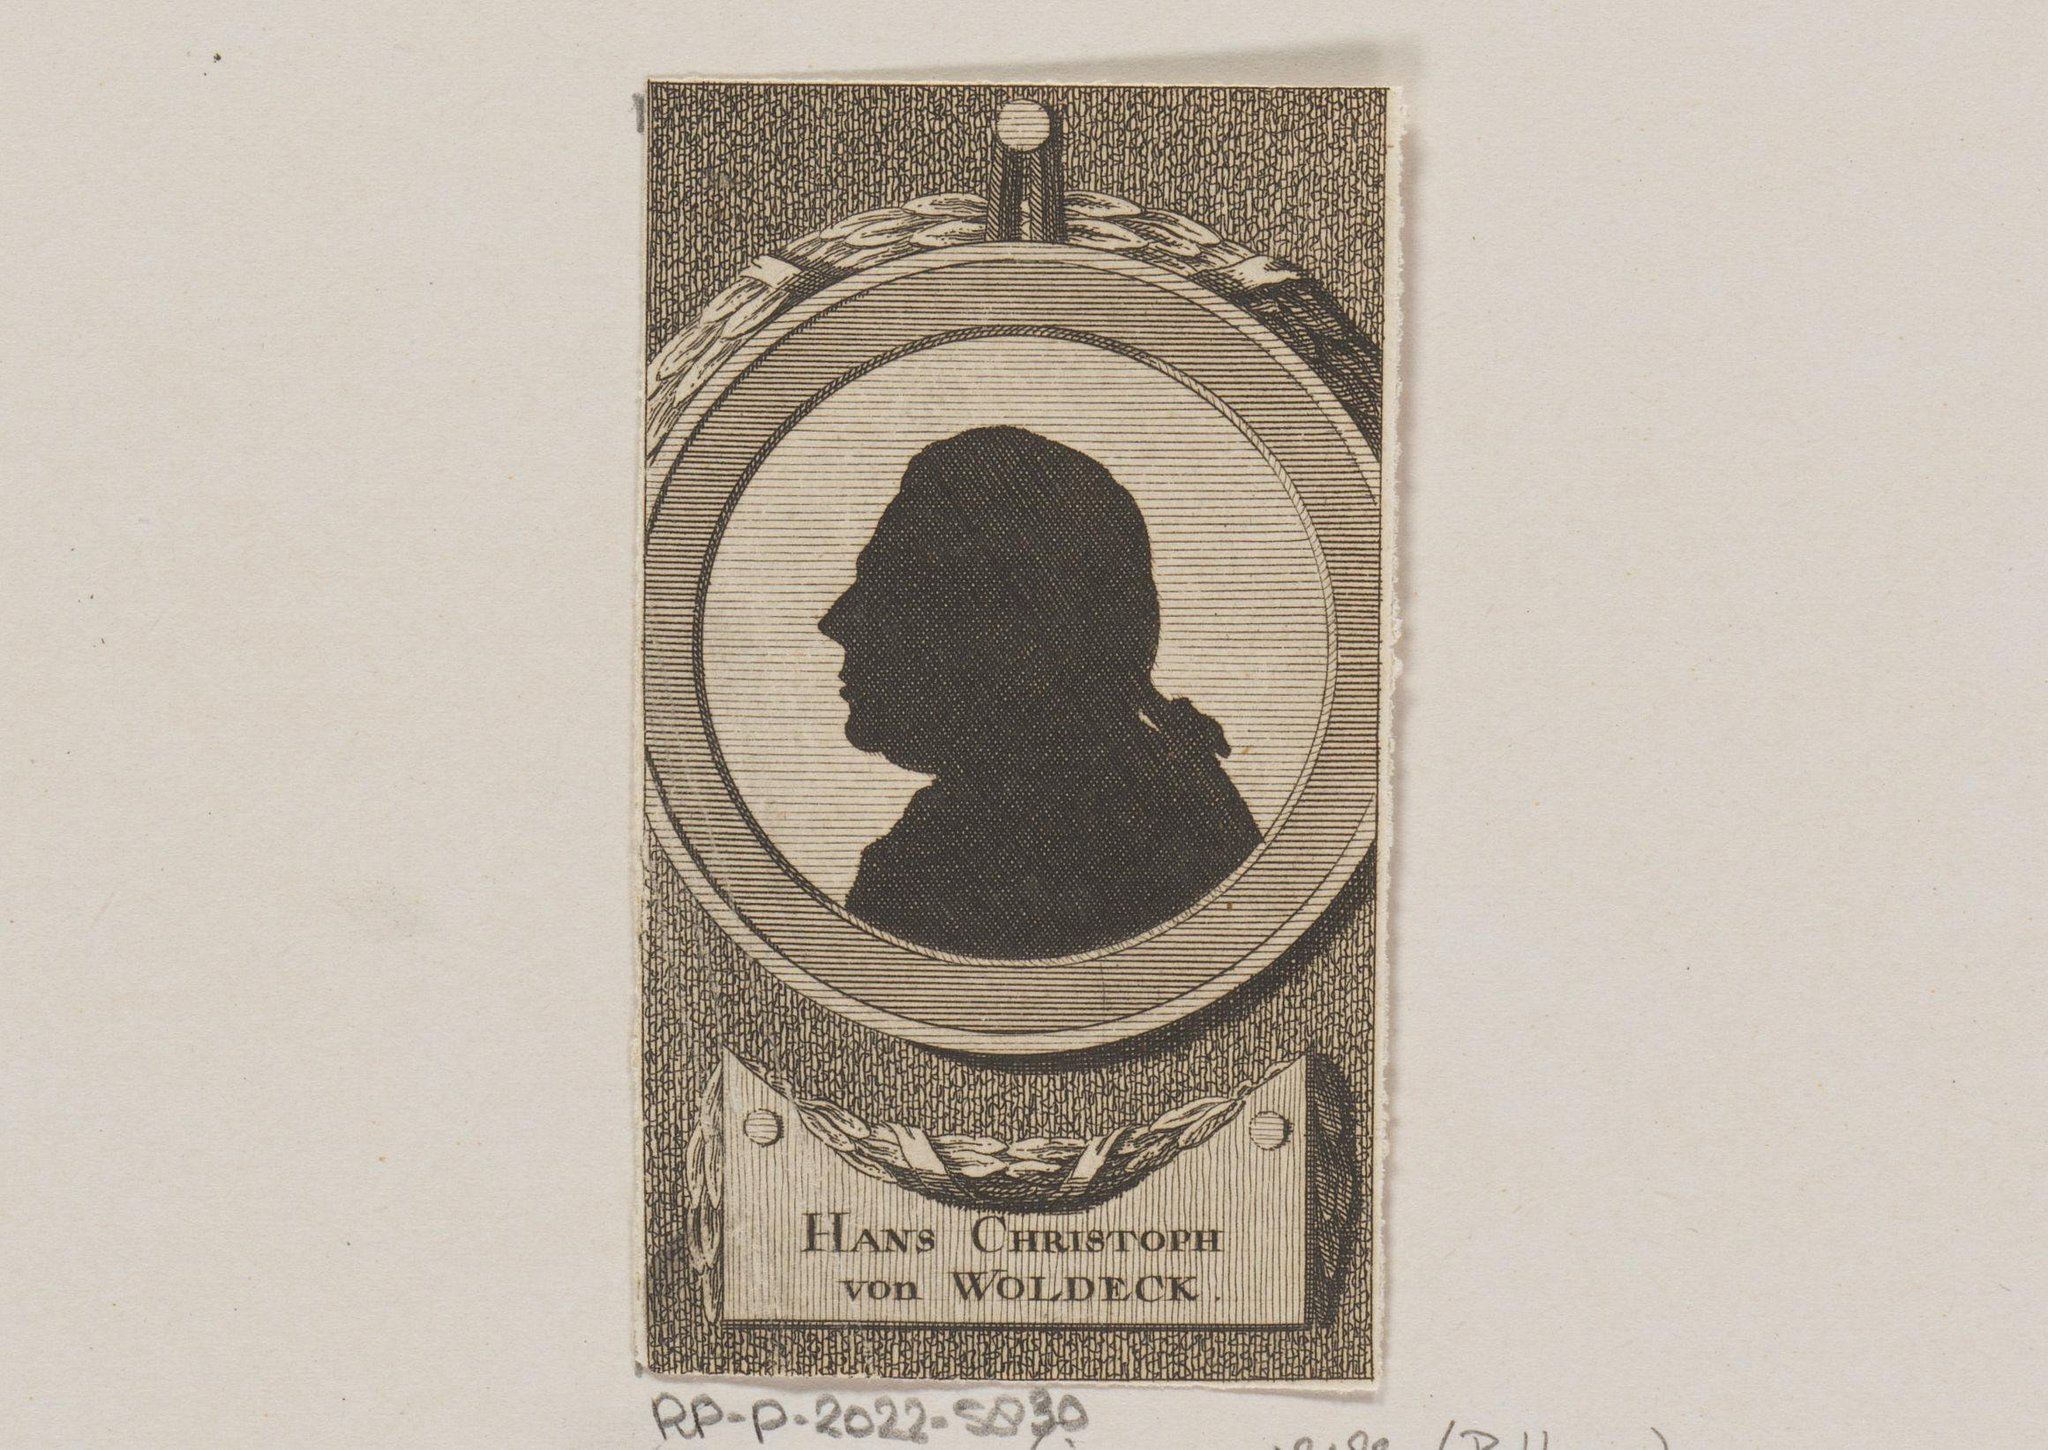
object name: print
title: Silhouetportret van Hans Christoph von Woldeck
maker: peter haas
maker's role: print maker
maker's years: 1754-1804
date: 1764-1804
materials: paper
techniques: etching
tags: commander-in-chief, general, marshal, historical persons